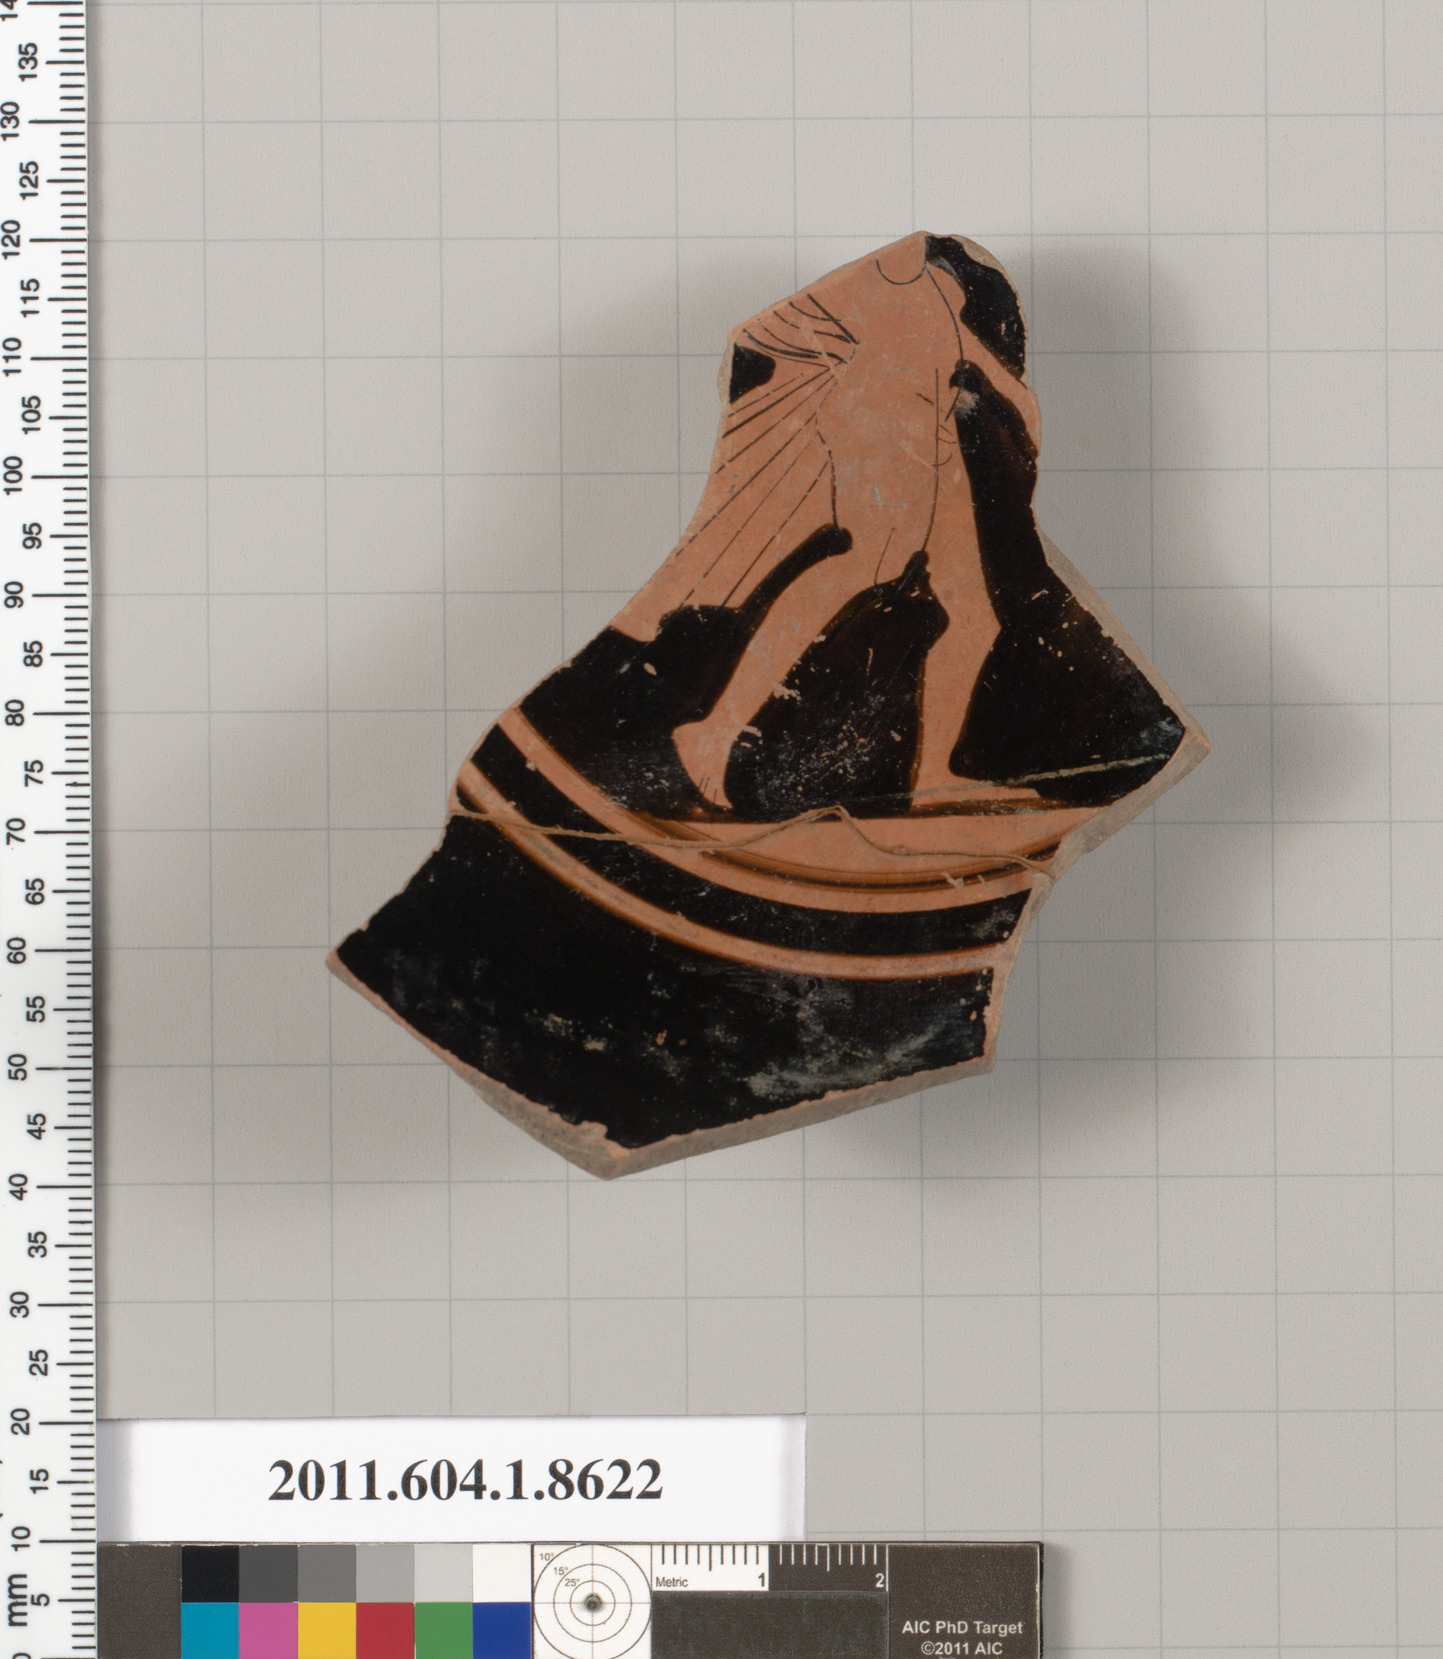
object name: kylix fragment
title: Terracotta fragment of a stemless kylix (drinking cup)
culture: greek, attic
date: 467-435 BCE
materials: terracotta